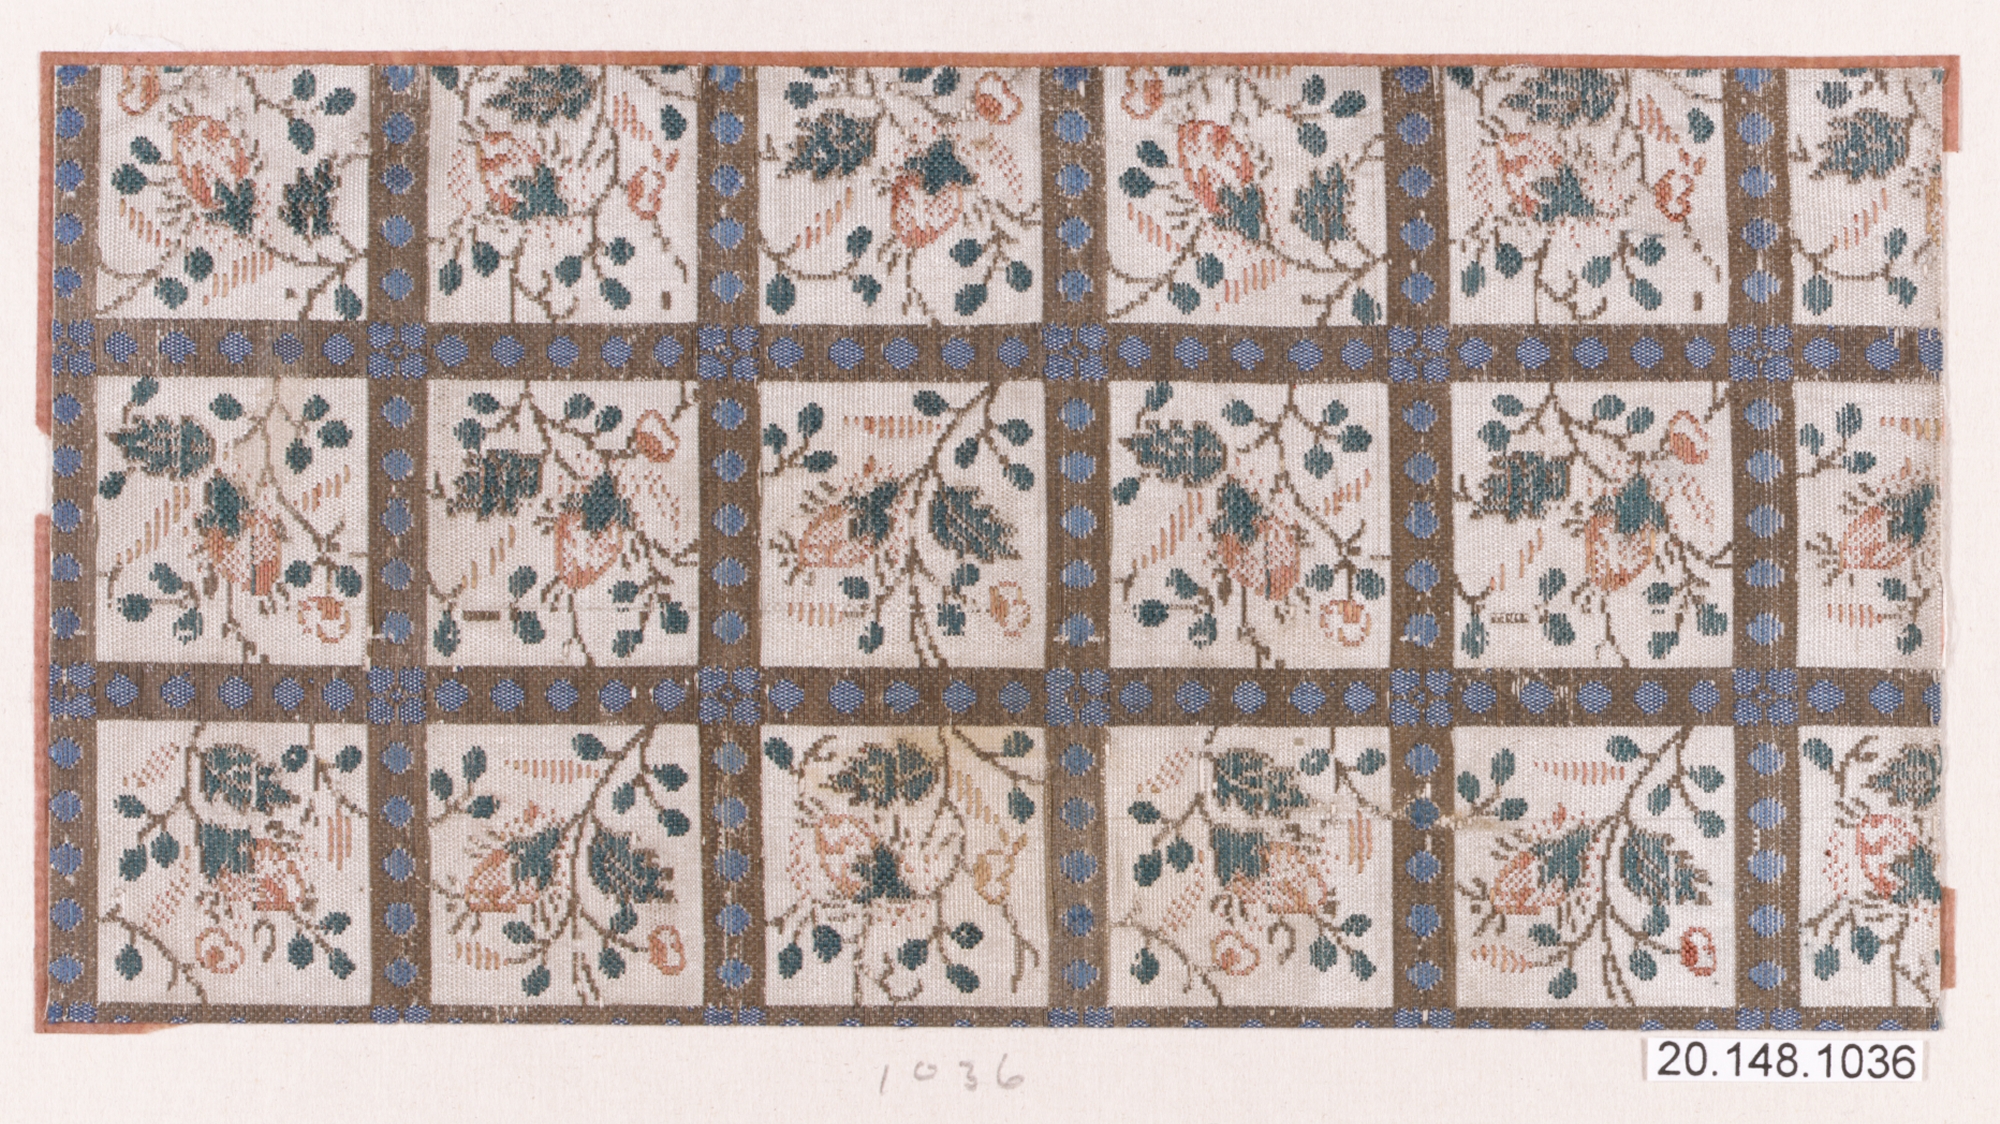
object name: piece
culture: japanese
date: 1701-1800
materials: silk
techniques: compound weave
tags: flowers,leaves